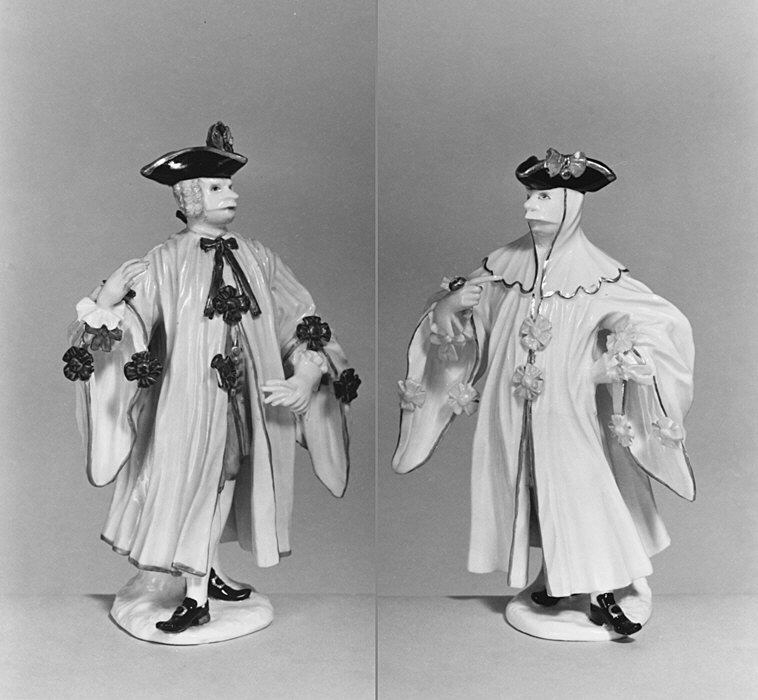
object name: figure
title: Avvocato (one of a pair)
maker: meissen manufactory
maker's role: manufactory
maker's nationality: german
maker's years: 1710-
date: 1745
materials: hard paste porcelain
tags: men